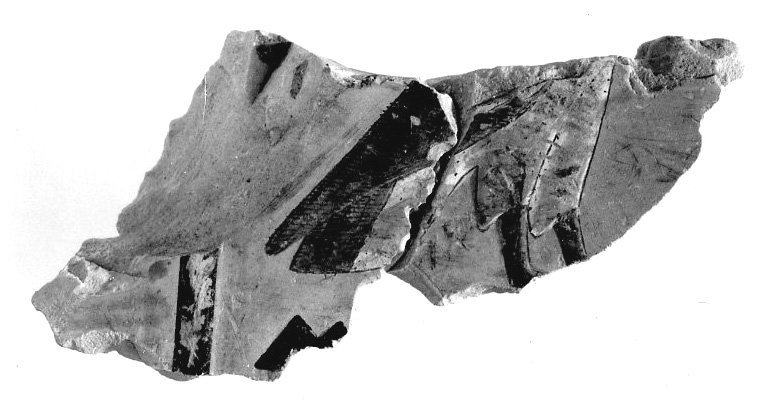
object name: relief fragment, tomb of meketre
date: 1981-1975 BCE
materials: limestone, paint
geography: egypt